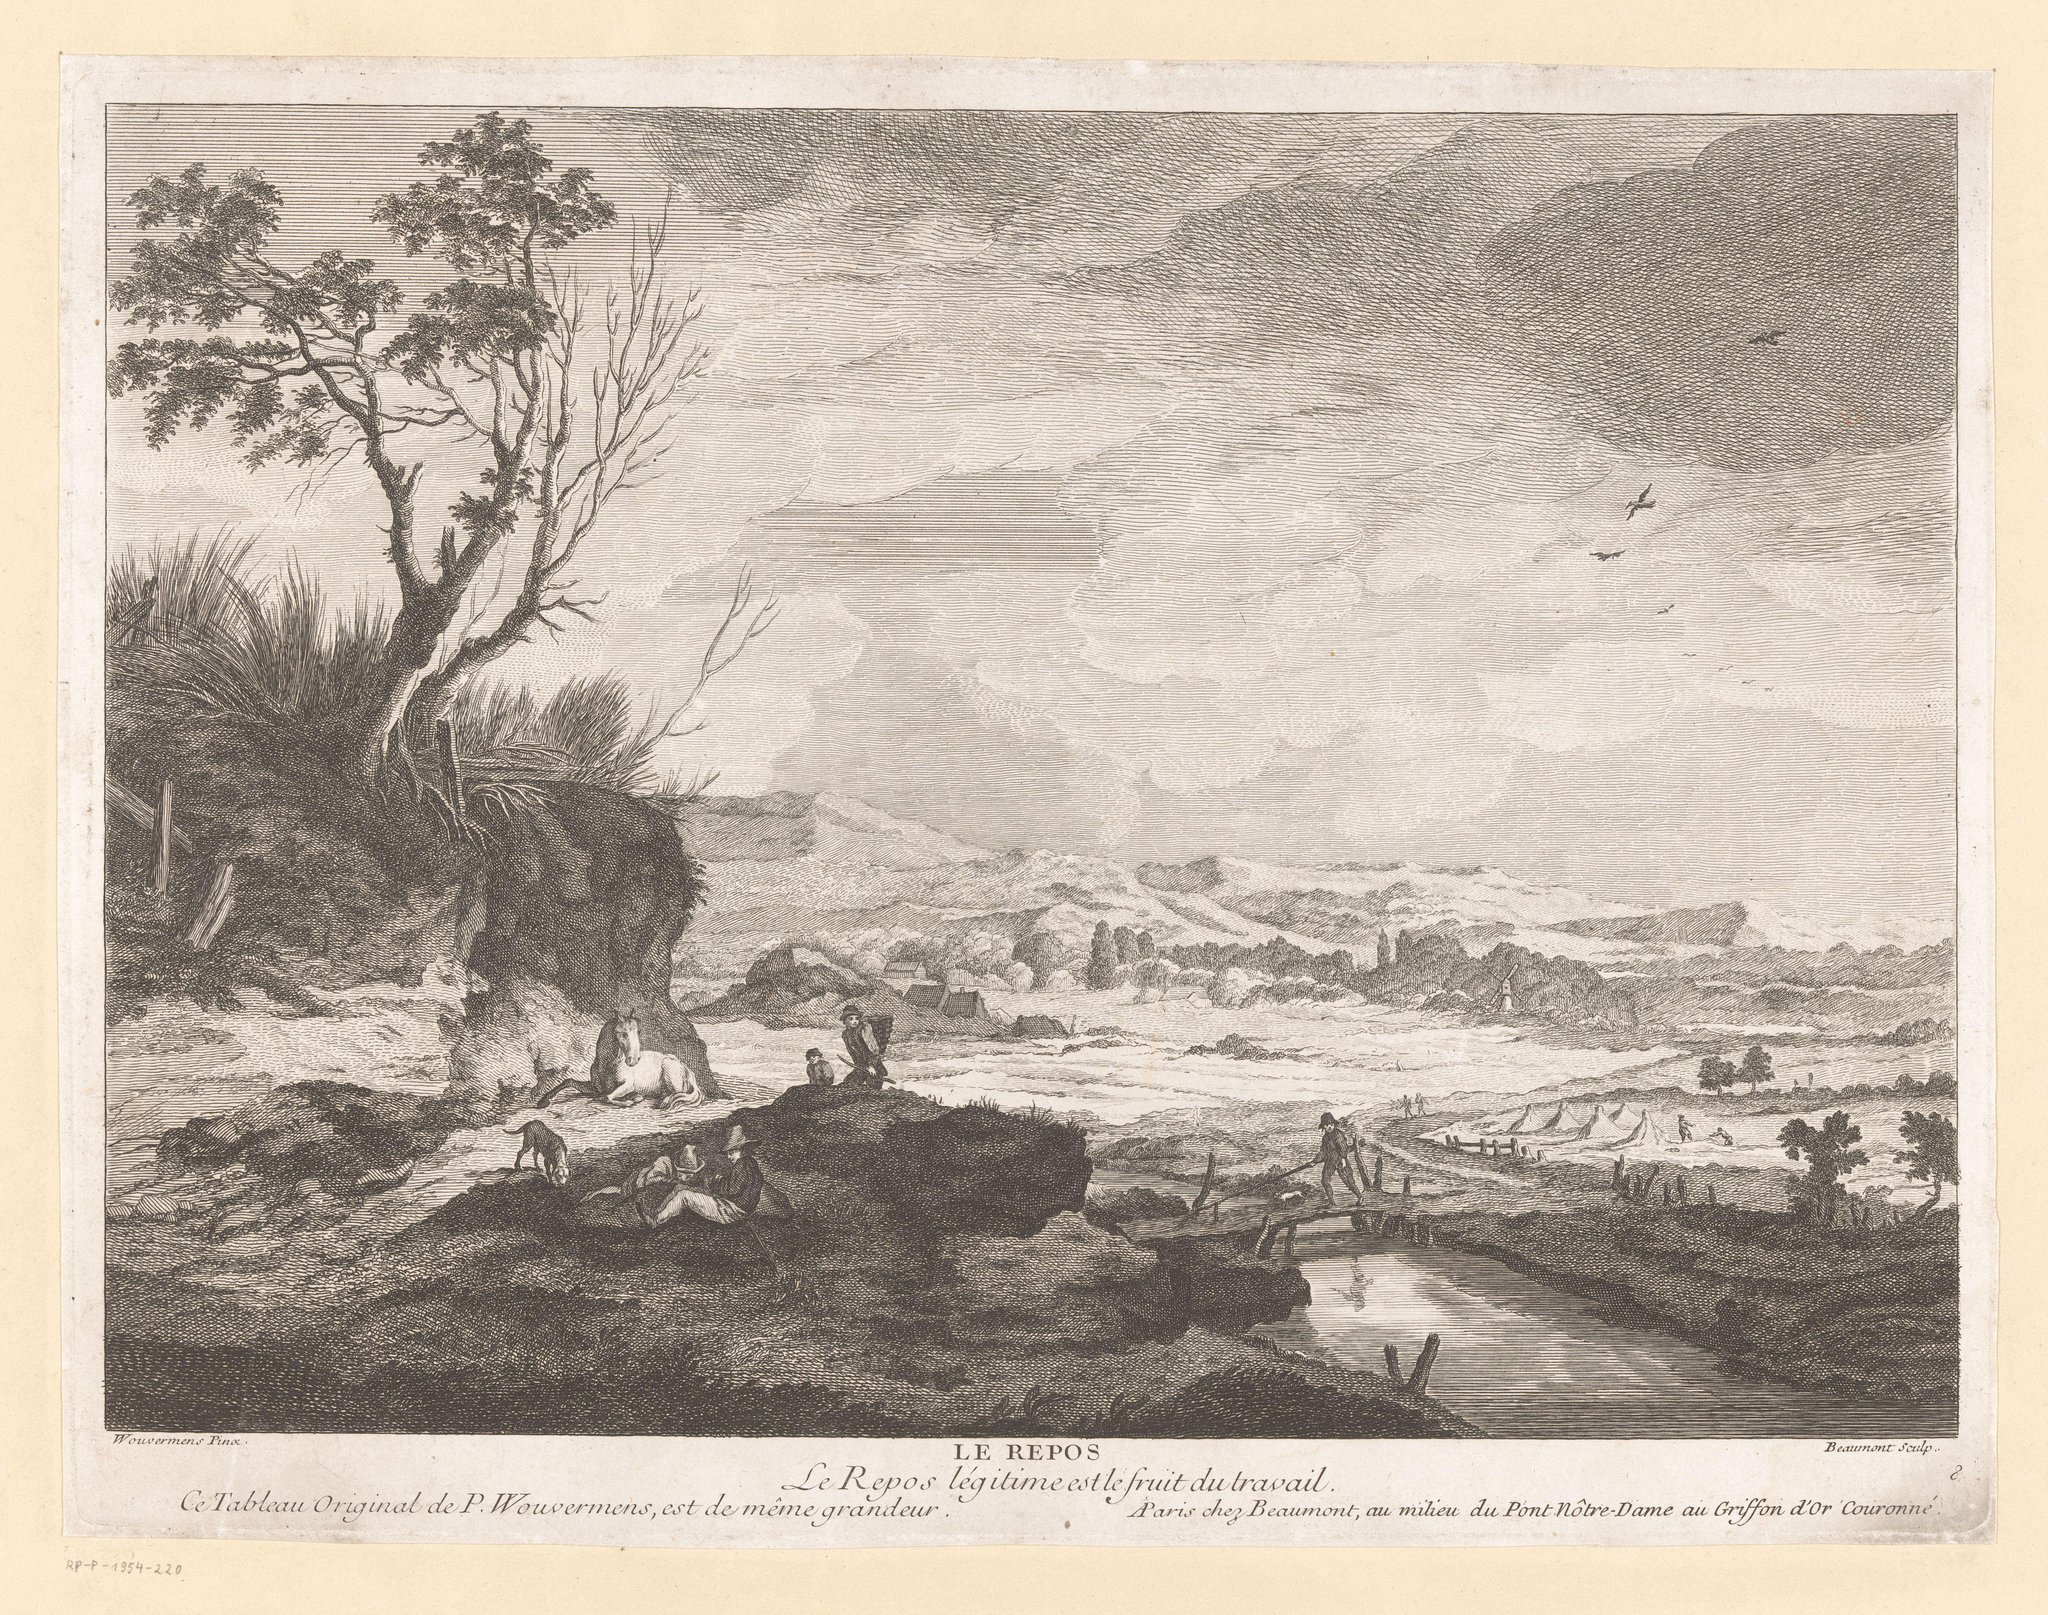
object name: print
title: Le repos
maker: pierre françois beaumont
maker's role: print maker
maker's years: 1719-1769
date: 1729-1769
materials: paper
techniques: etching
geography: paris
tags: river, resting - bb - out of doors, landscapes - hh - ideal landscapes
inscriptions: collector's mark: Lugt 2028, collector's mark: Lugt 2228, collector's mark: Lugt 2760